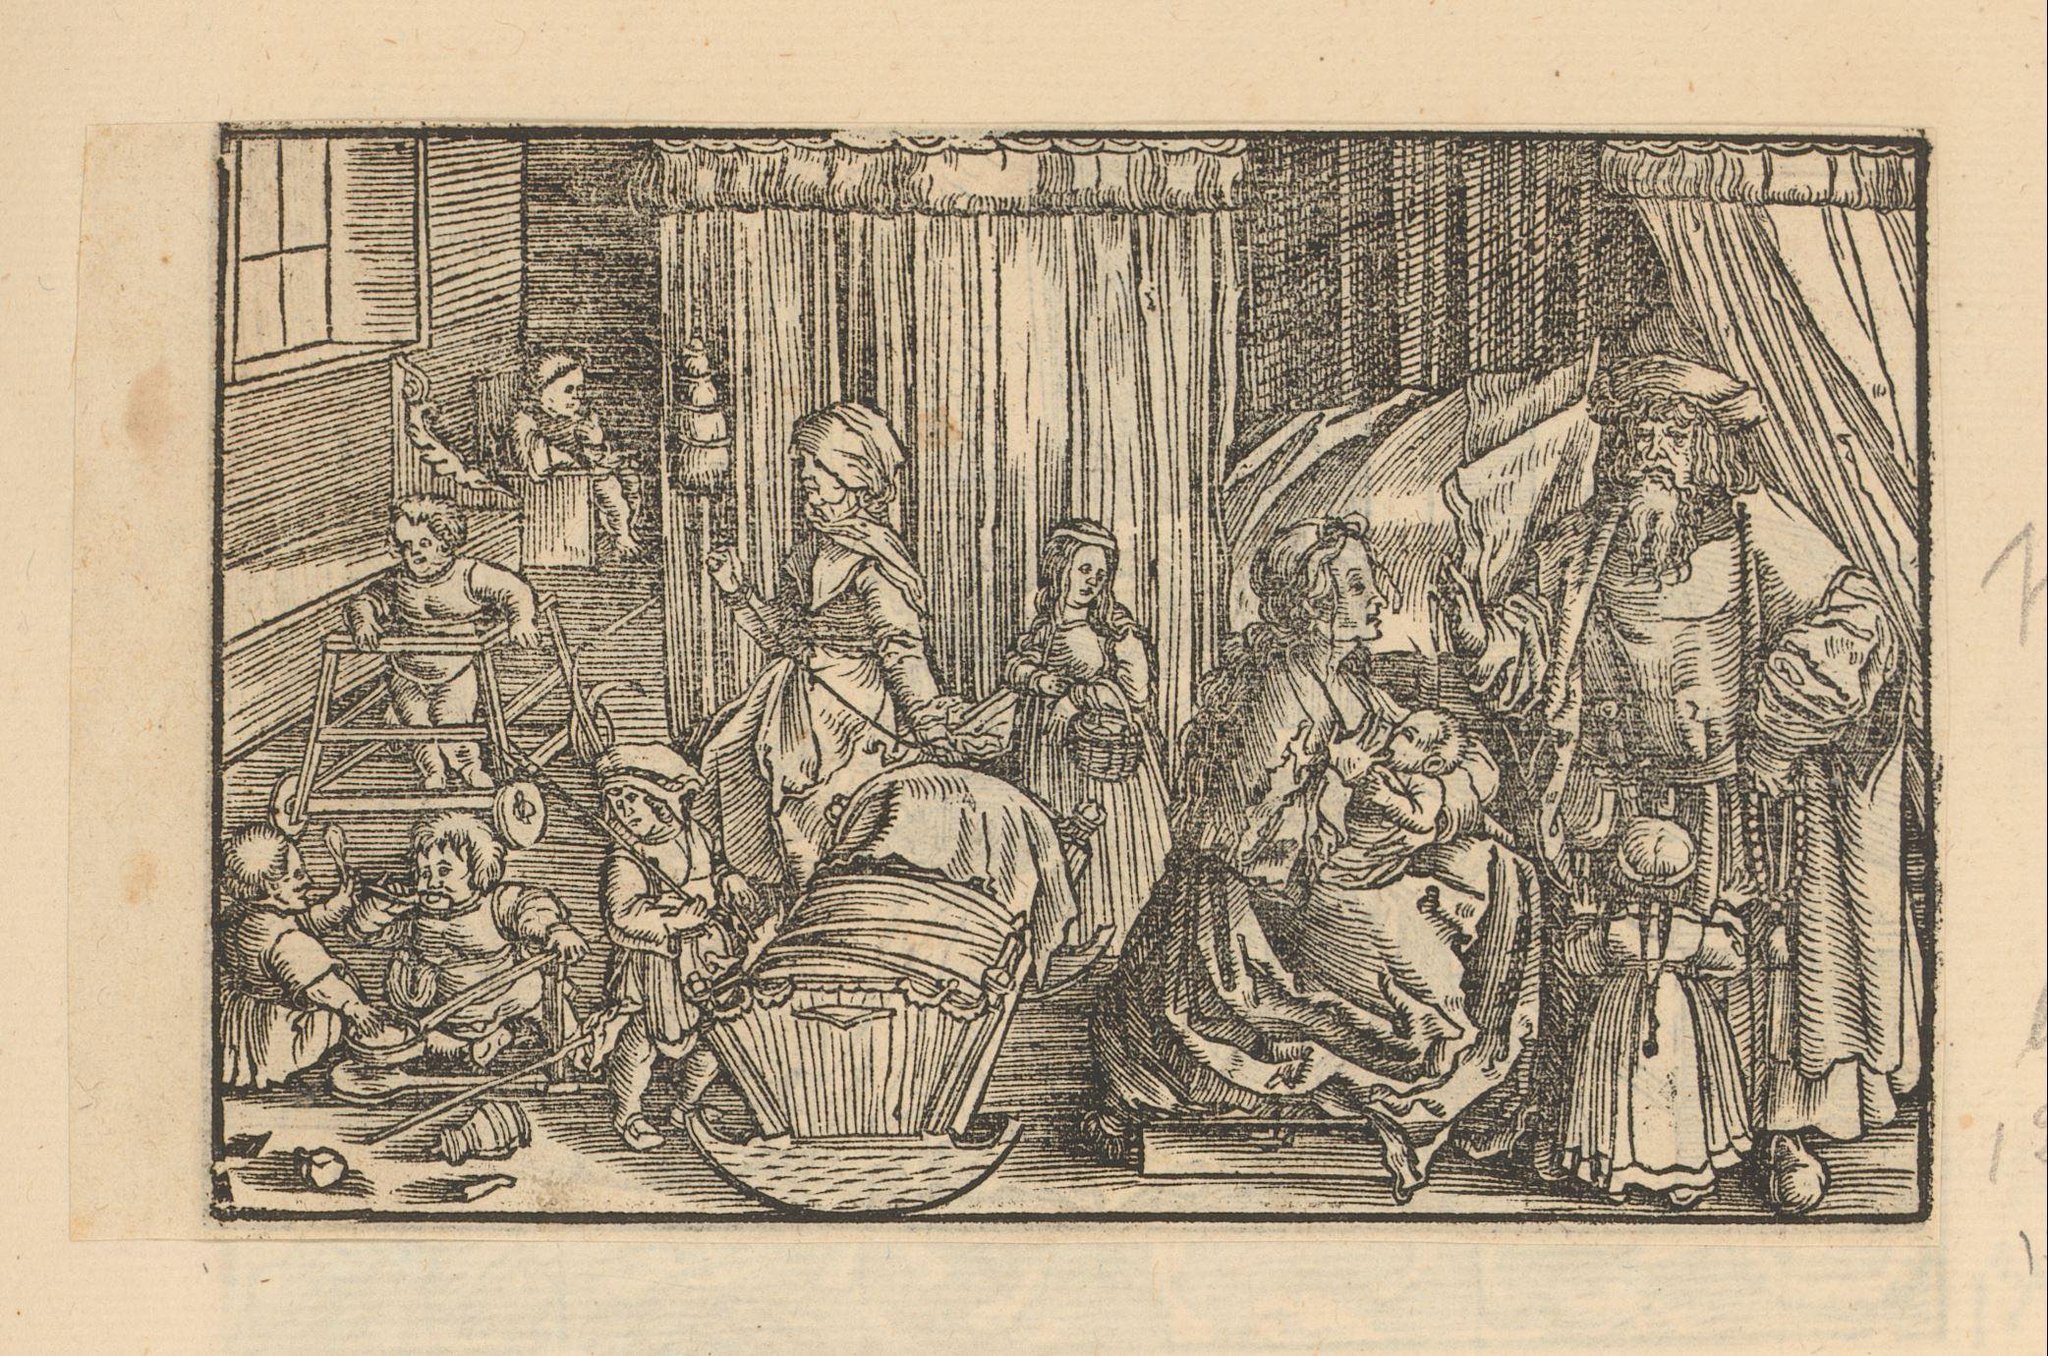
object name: print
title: Grote familie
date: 1514-1532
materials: paper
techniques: letterpress printing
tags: family life at home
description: Deze prent is gebruikt in: Petrarca, Francesco. Von der Artzney bayder Glück, des guten und widerwertigen: unnd weß sich ain yeder inn Gelück und Unglück halten sol (...). Augsburg: Heinrich Steiner, 1532. Deze uitgave is ook bekend onder de titel 'Trostspiegel in Glück und Unglück'. Deze prent is ook gebruikt in: Cicero, Marcus Tulius. Officia M.T.C. Ein Buch so Marcus Tullius Cicero der Römer zu seynem (...). [Vertaald uit het Latijn door] Johann von Schwarzenberg. Augsburg: Heinrich Steiner, 1531.